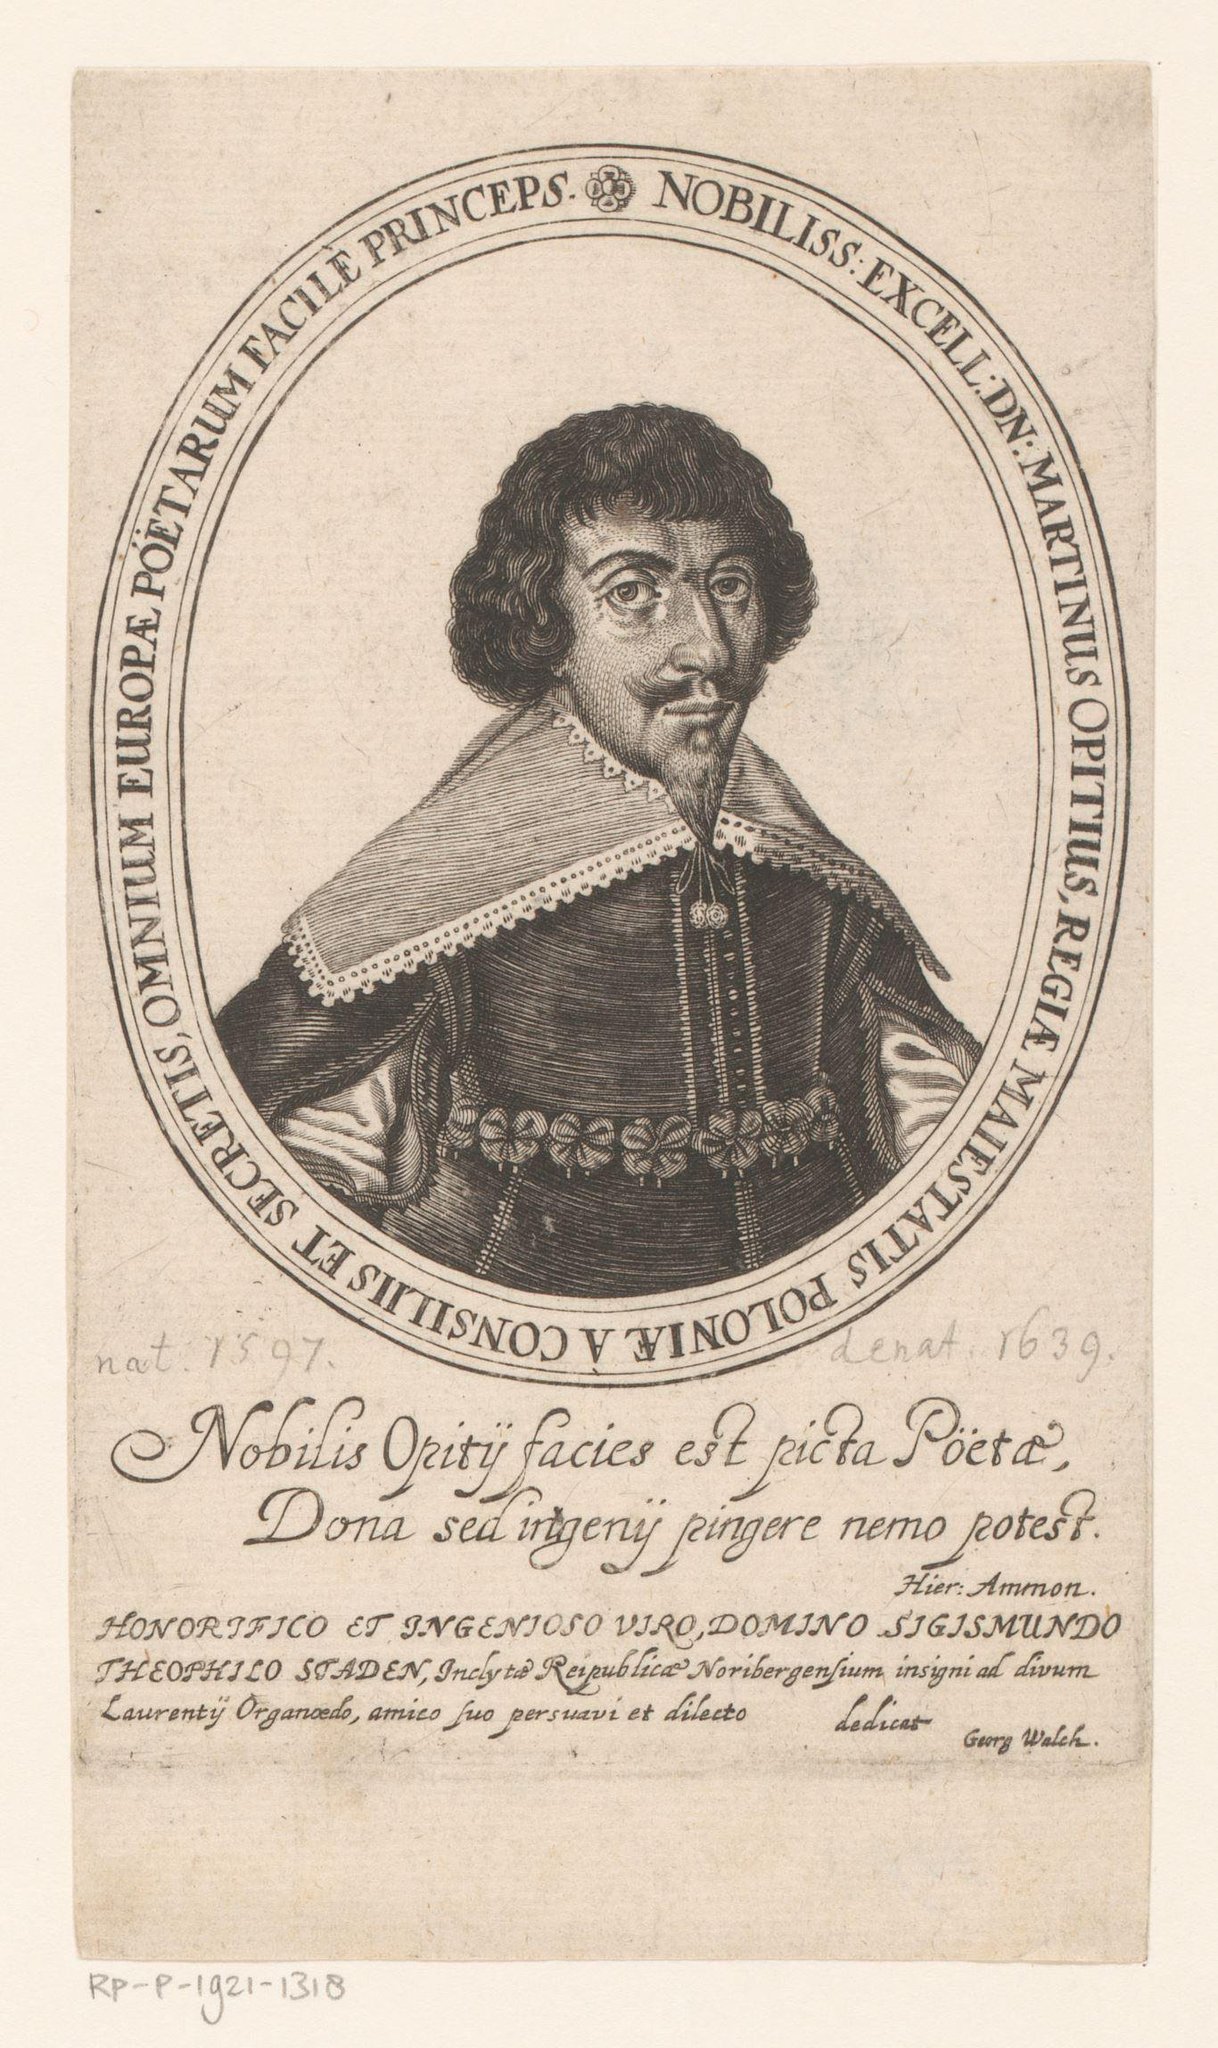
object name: print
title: Portret van Martin Opitz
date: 1632-1654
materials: paper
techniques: engraving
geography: germany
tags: poland, martin opitz, historical persons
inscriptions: collector's mark: Lugt 2228